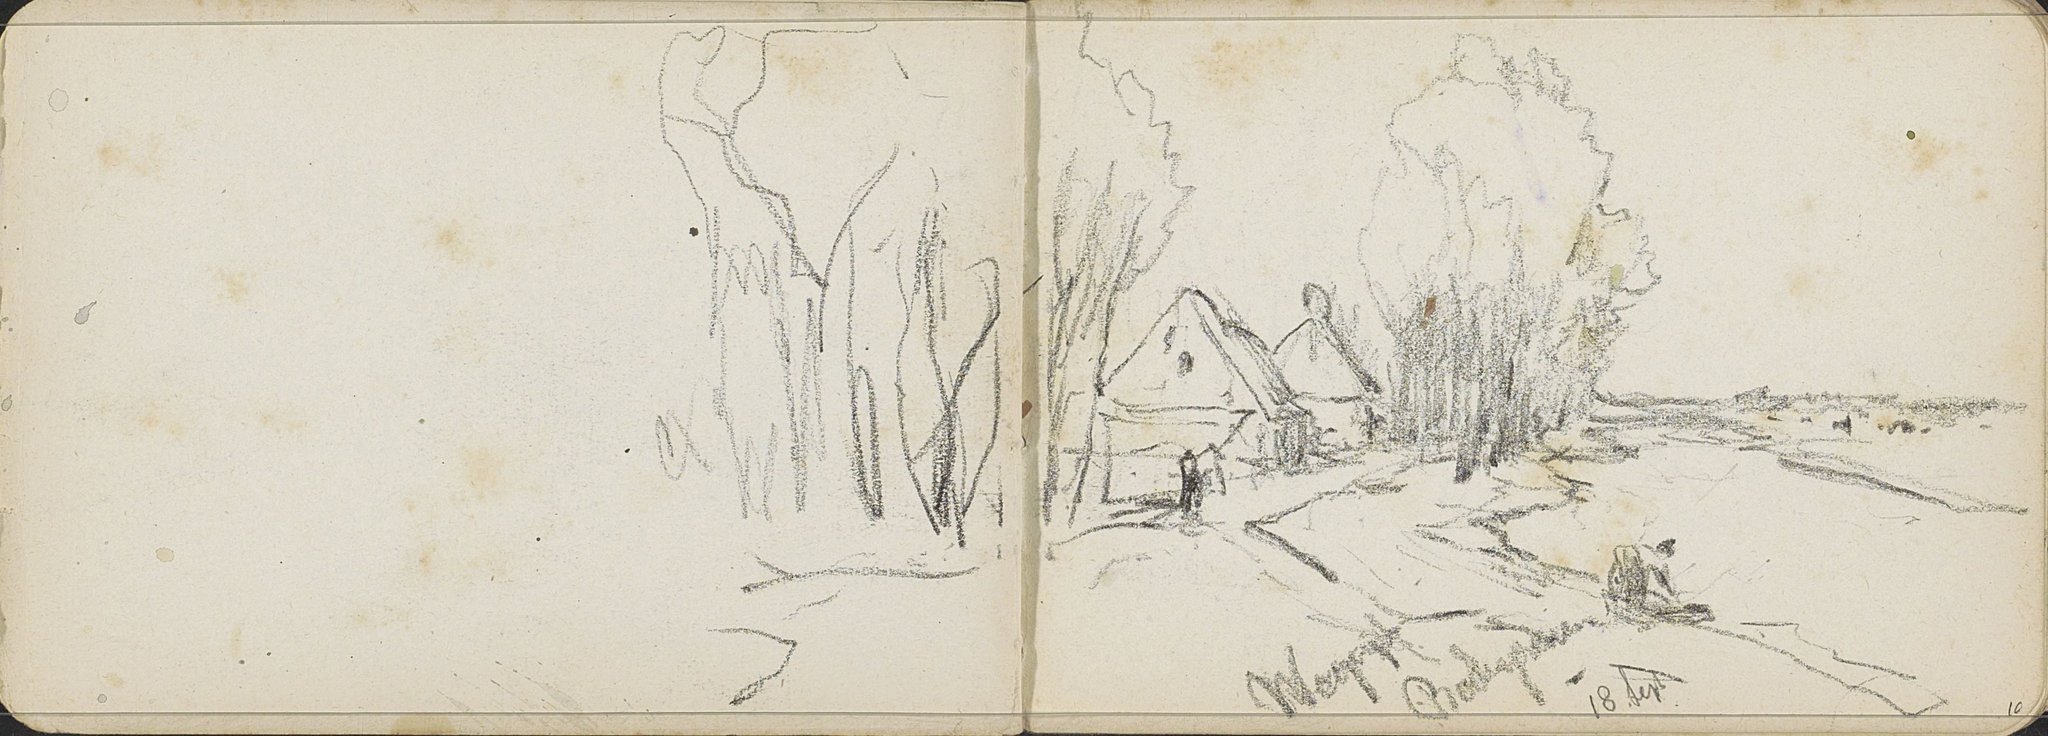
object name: sketchbook leaf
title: Huizen aan een dijk te Bodegraven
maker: willem cornelis rip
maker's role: draughtsman, painter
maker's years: 1856-1922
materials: chalk, paper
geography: bodegraven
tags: landscapes with waters, waterscapes, seascapes (in the temperate zone), village, bodegraven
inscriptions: date and inscription: ‘Weg[...]/ Bodegraven/ 18 Sept.’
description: Blad 9 verso en 10 recto uit een schetsboek met 44 bladen.